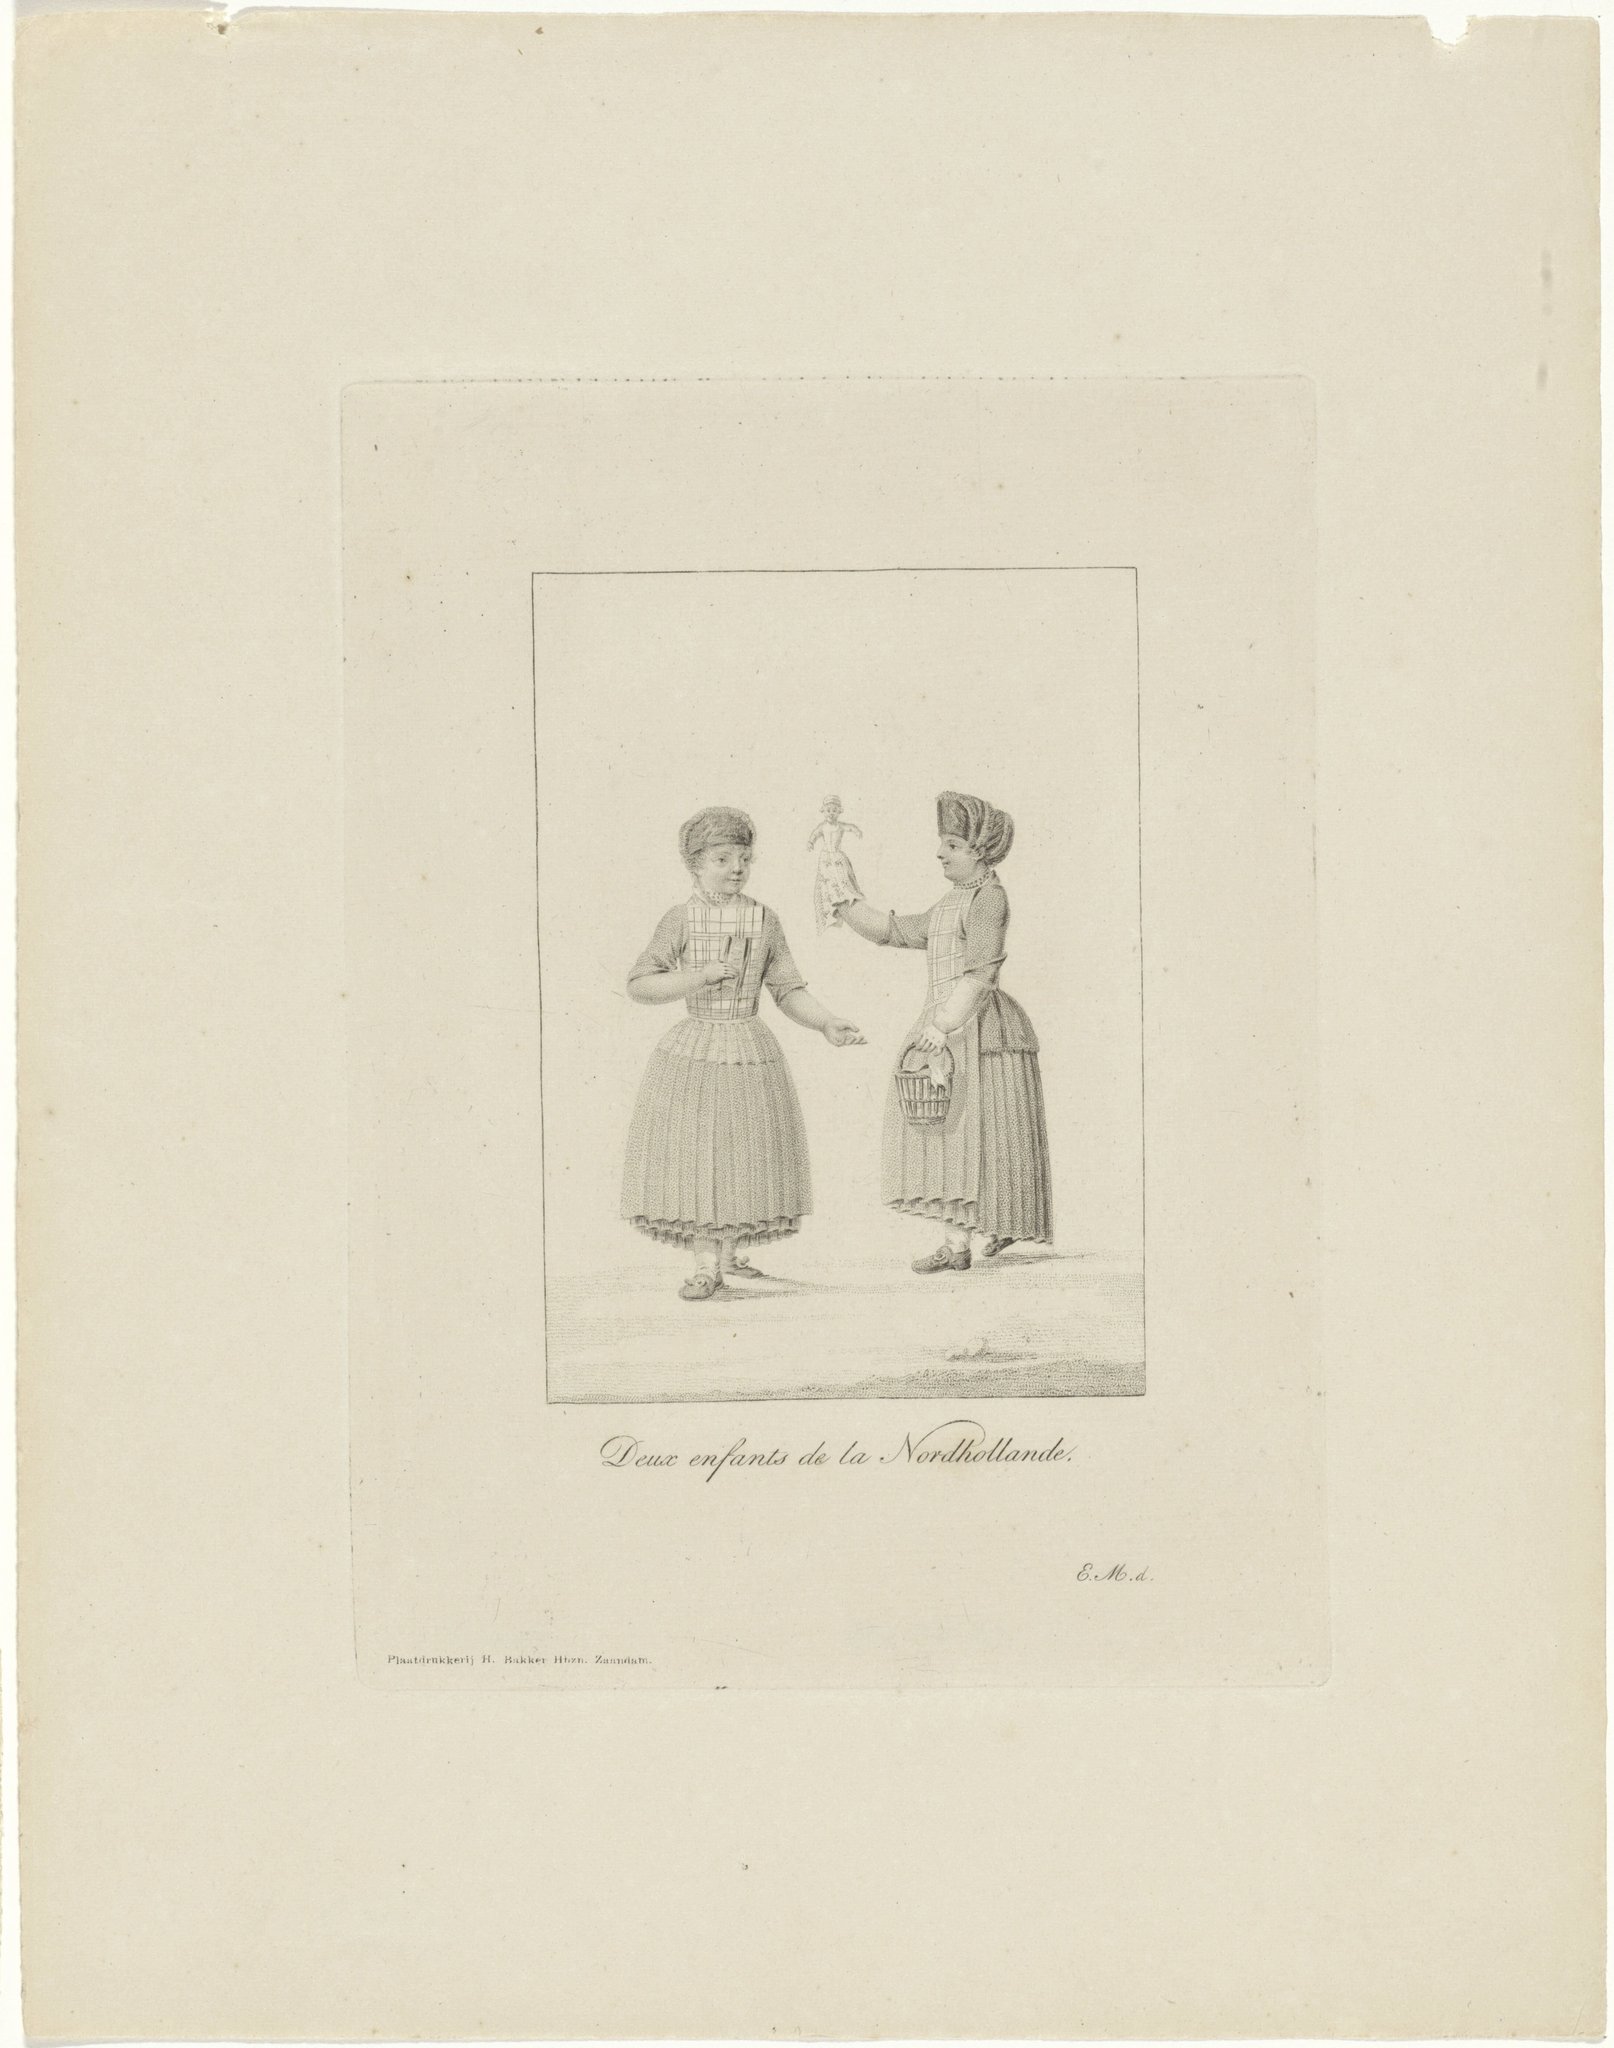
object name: print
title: Deux enfants de la Nordhollande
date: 1824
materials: paper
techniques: etching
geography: zaandam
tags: girl (child between toddler and youth), (playing with) dolls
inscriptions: collector's mark: Lugt 2228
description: Prent gebruikt in: Maaskamp, Evert. Tableau des principales vues des palais et édifices : représentations et des coutumes et usages, dans les provinces septentrionales du Royaume des Pays-Bas. Amsterdam, 1824.